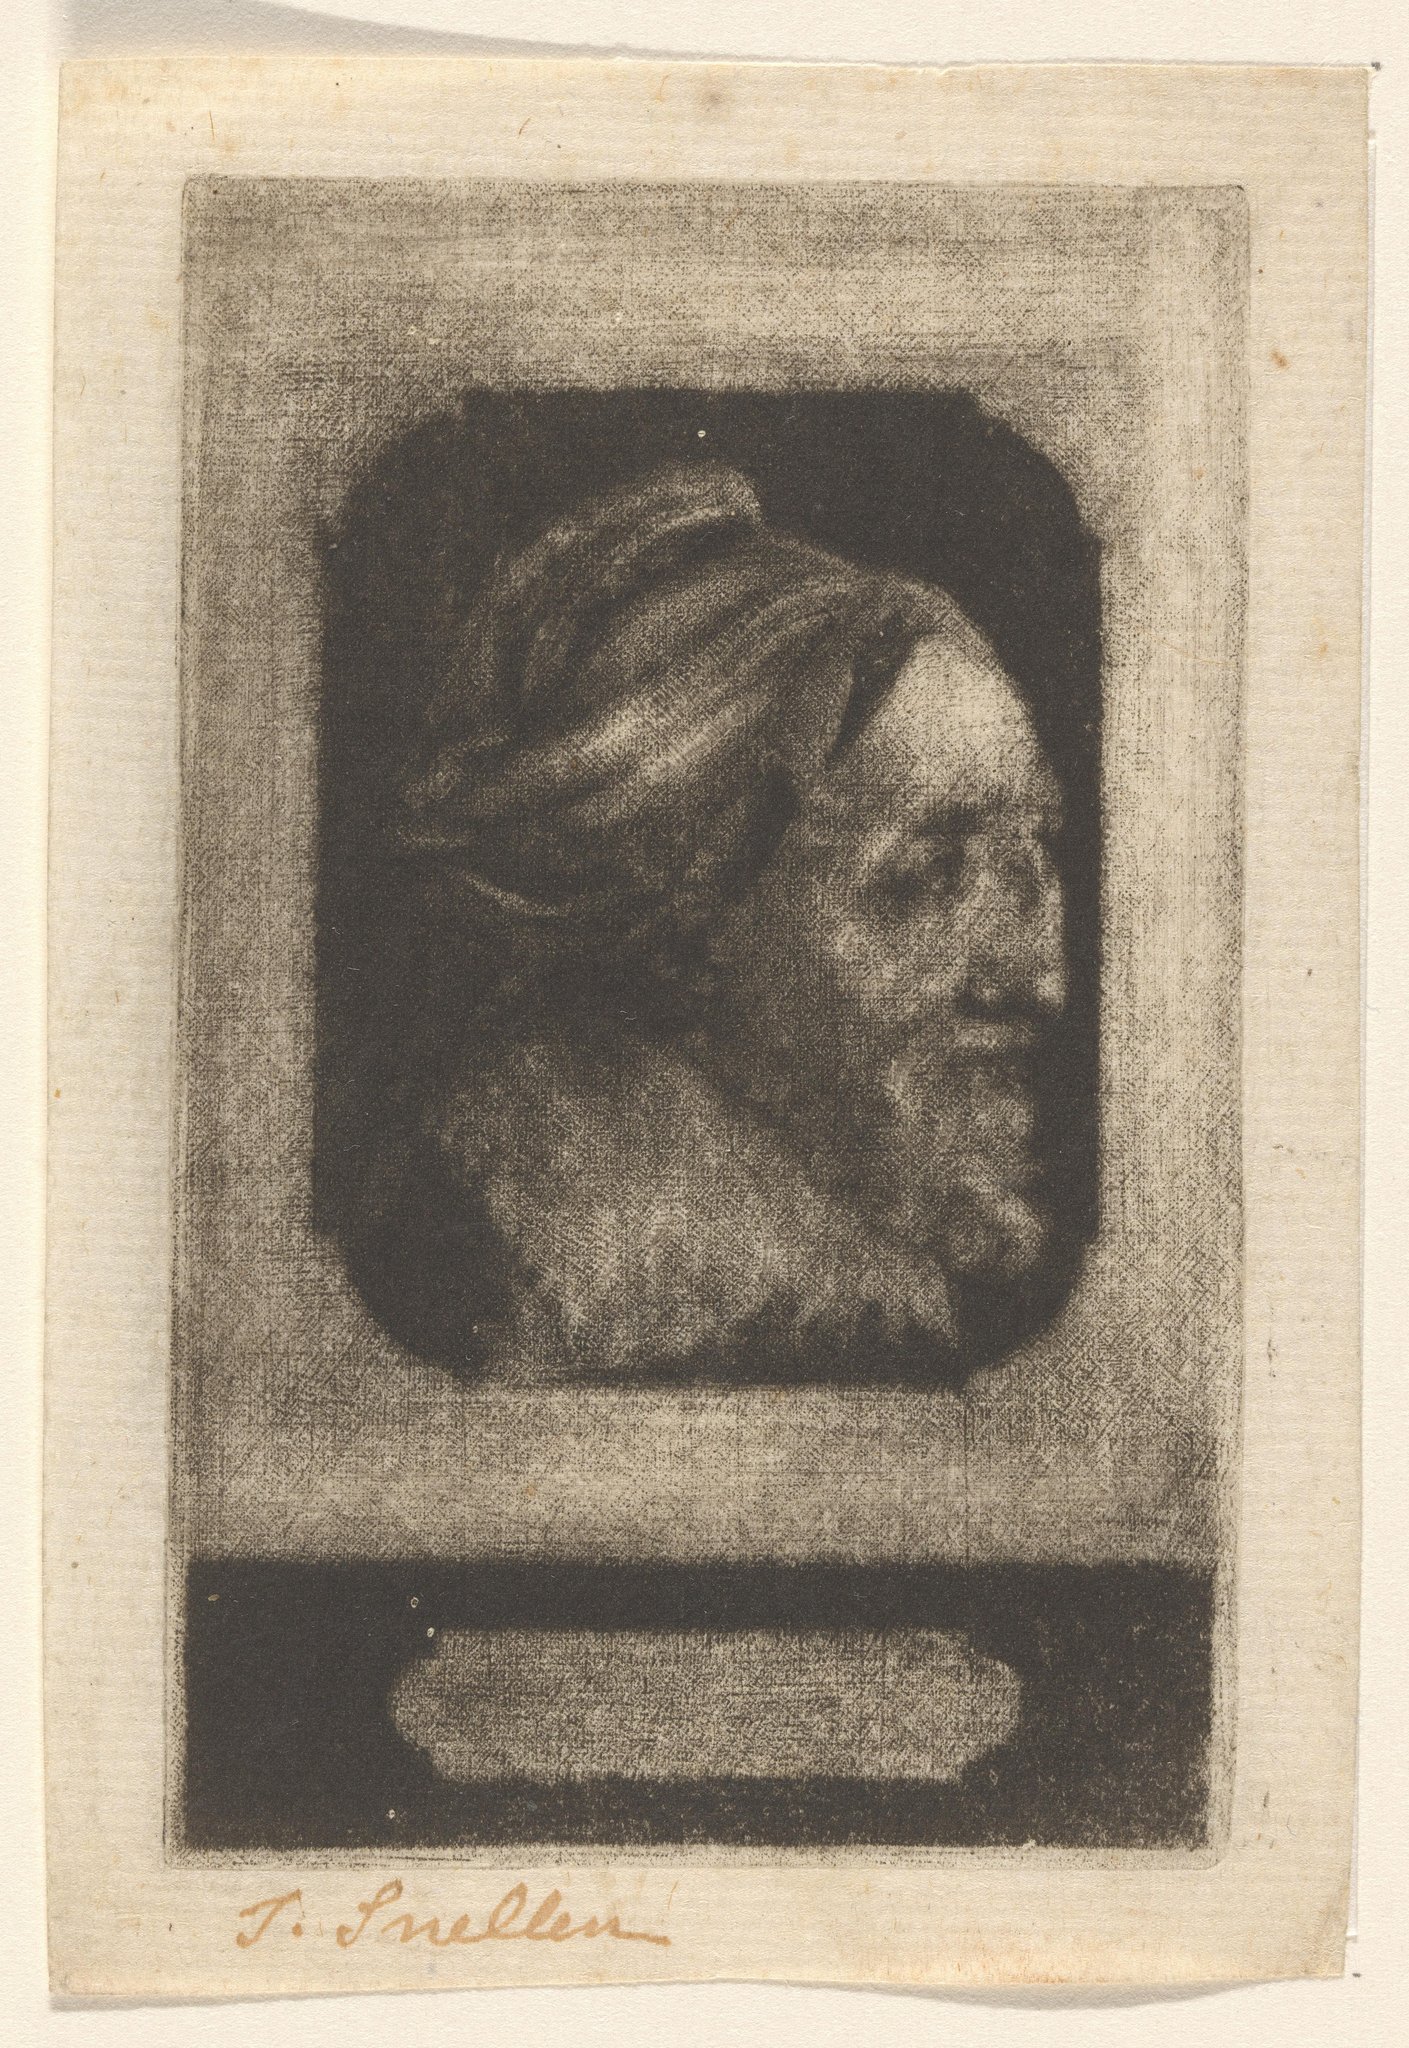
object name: print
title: Portret van Titiaan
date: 1601-1800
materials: paper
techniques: mezzotint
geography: netherlands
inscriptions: inscription: ‘J. Snelle’